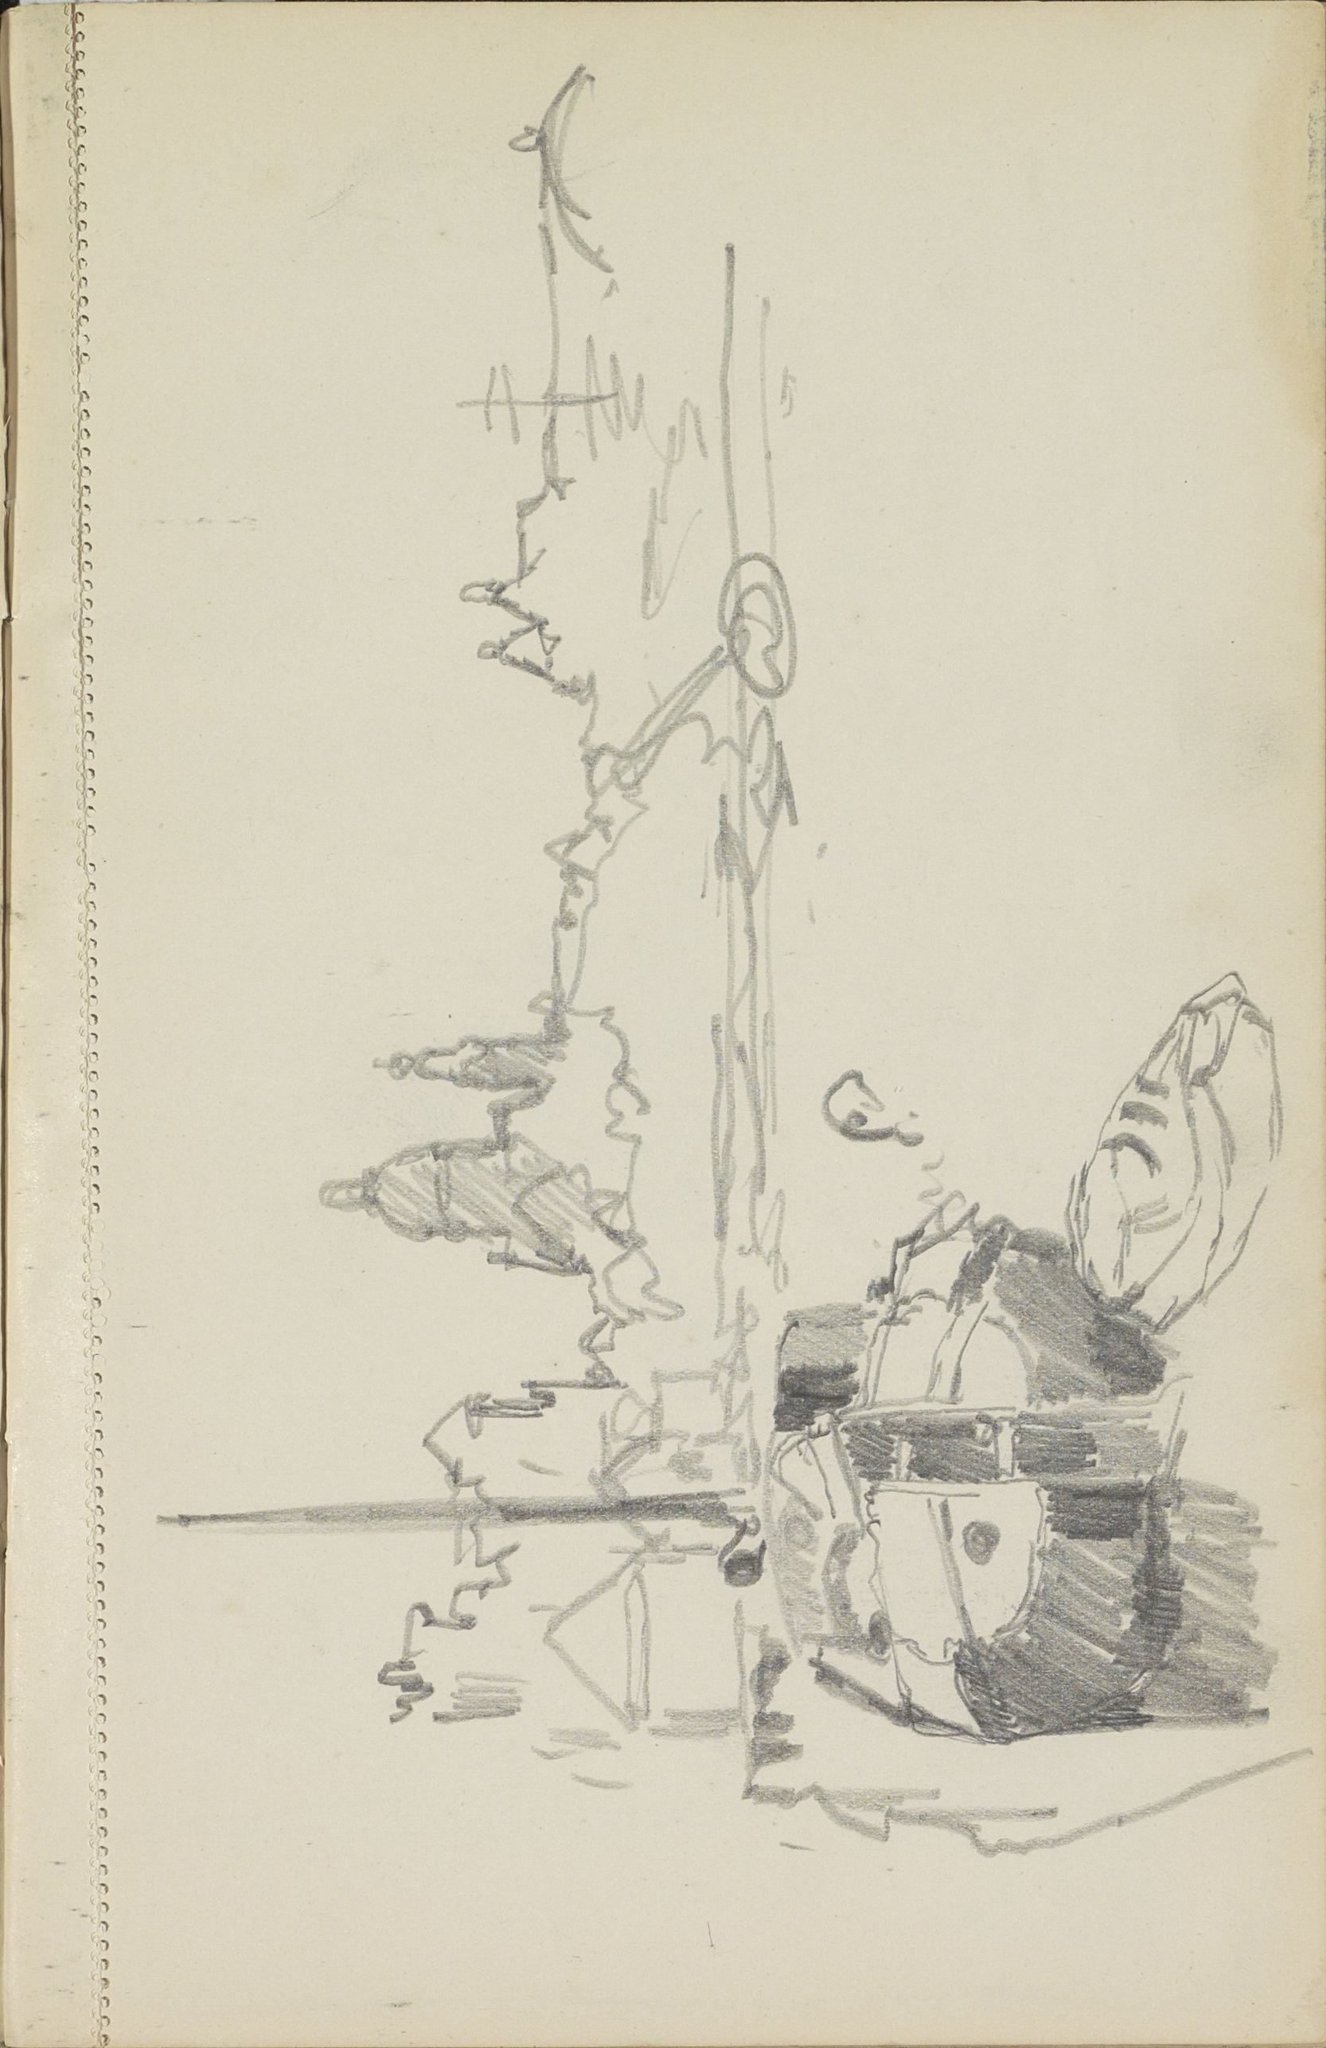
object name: sketchbook leaf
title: Aangemeerde boot op de Prins Hendrikkade te Amsterdam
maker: cornelis vreedenburgh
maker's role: draughtsman, print maker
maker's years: 1880-1946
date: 1890-1946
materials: paper, pencil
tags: city-view, and landscape with man-made constructions, sailing-ship, sailing-boat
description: Op de achtergrond de Schreierstoren en Nicolaaskerk. Blad 26 recto uit een schetsboek met 56 bladen.